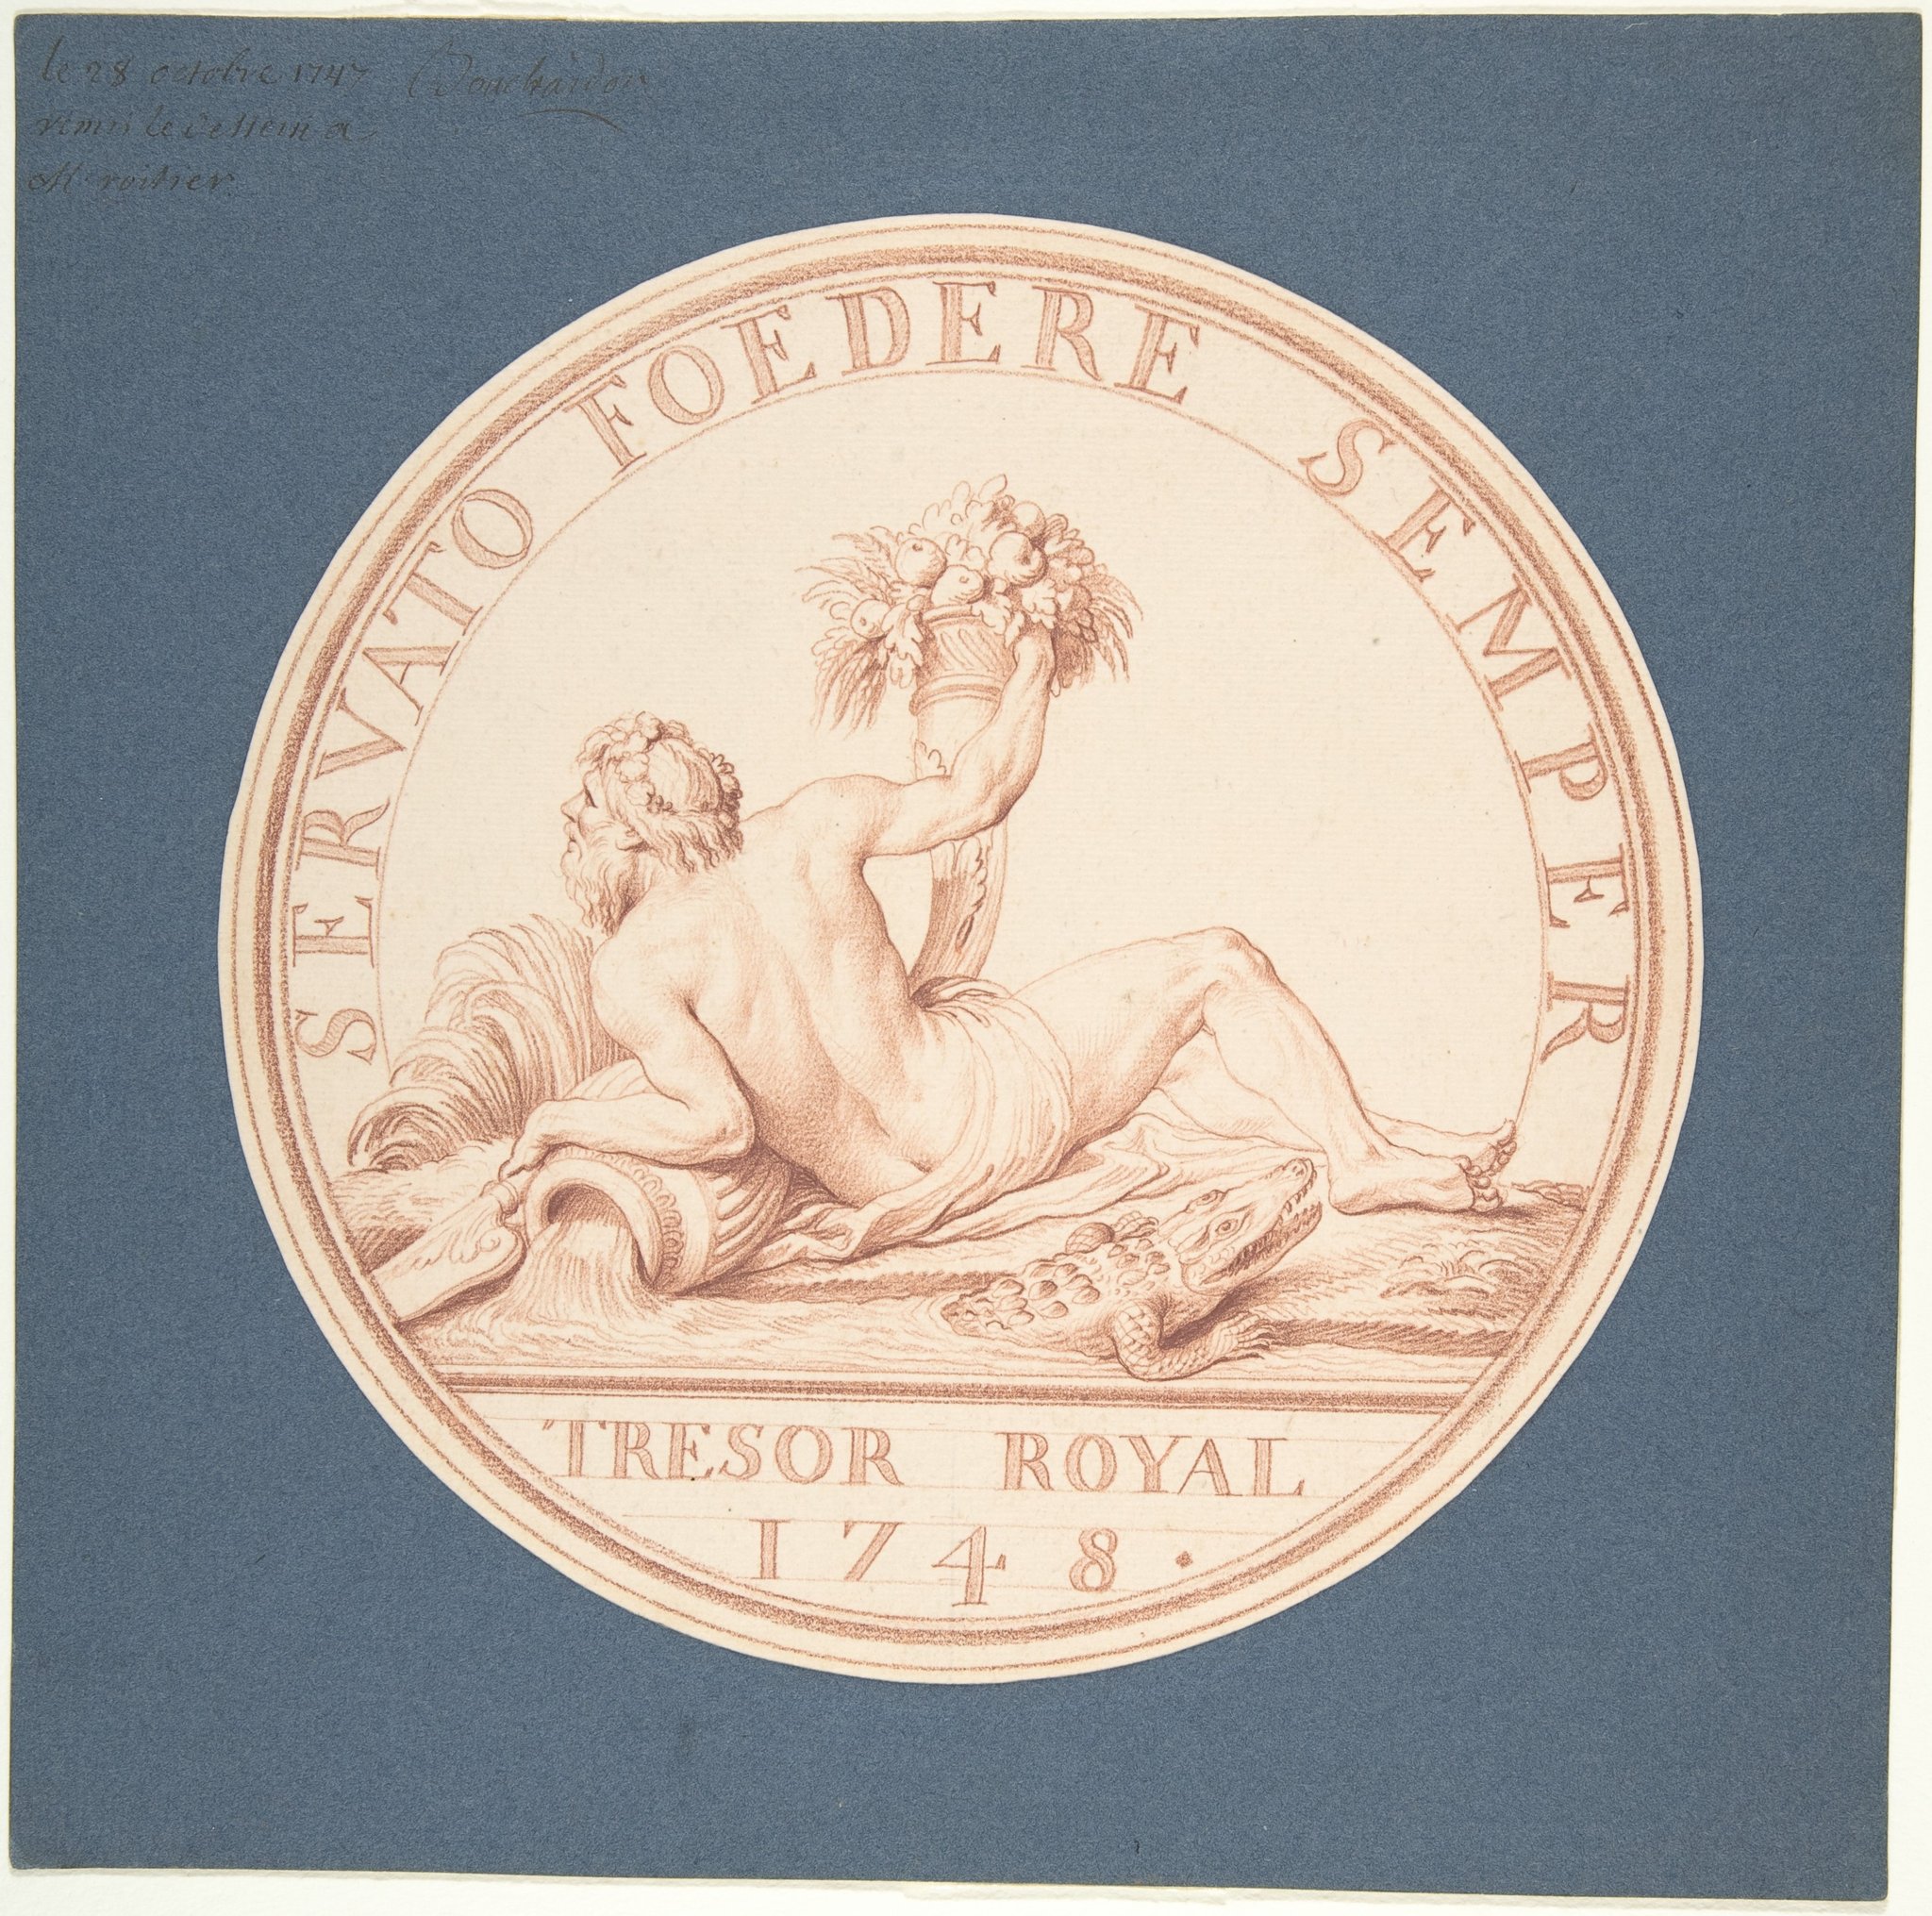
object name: drawing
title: Design for a Token: Trésor Royal 1748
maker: edme bouchardon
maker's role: artist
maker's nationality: french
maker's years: 1698-1762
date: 1748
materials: chalk, paper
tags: men,crocodiles,cornucopia,vases